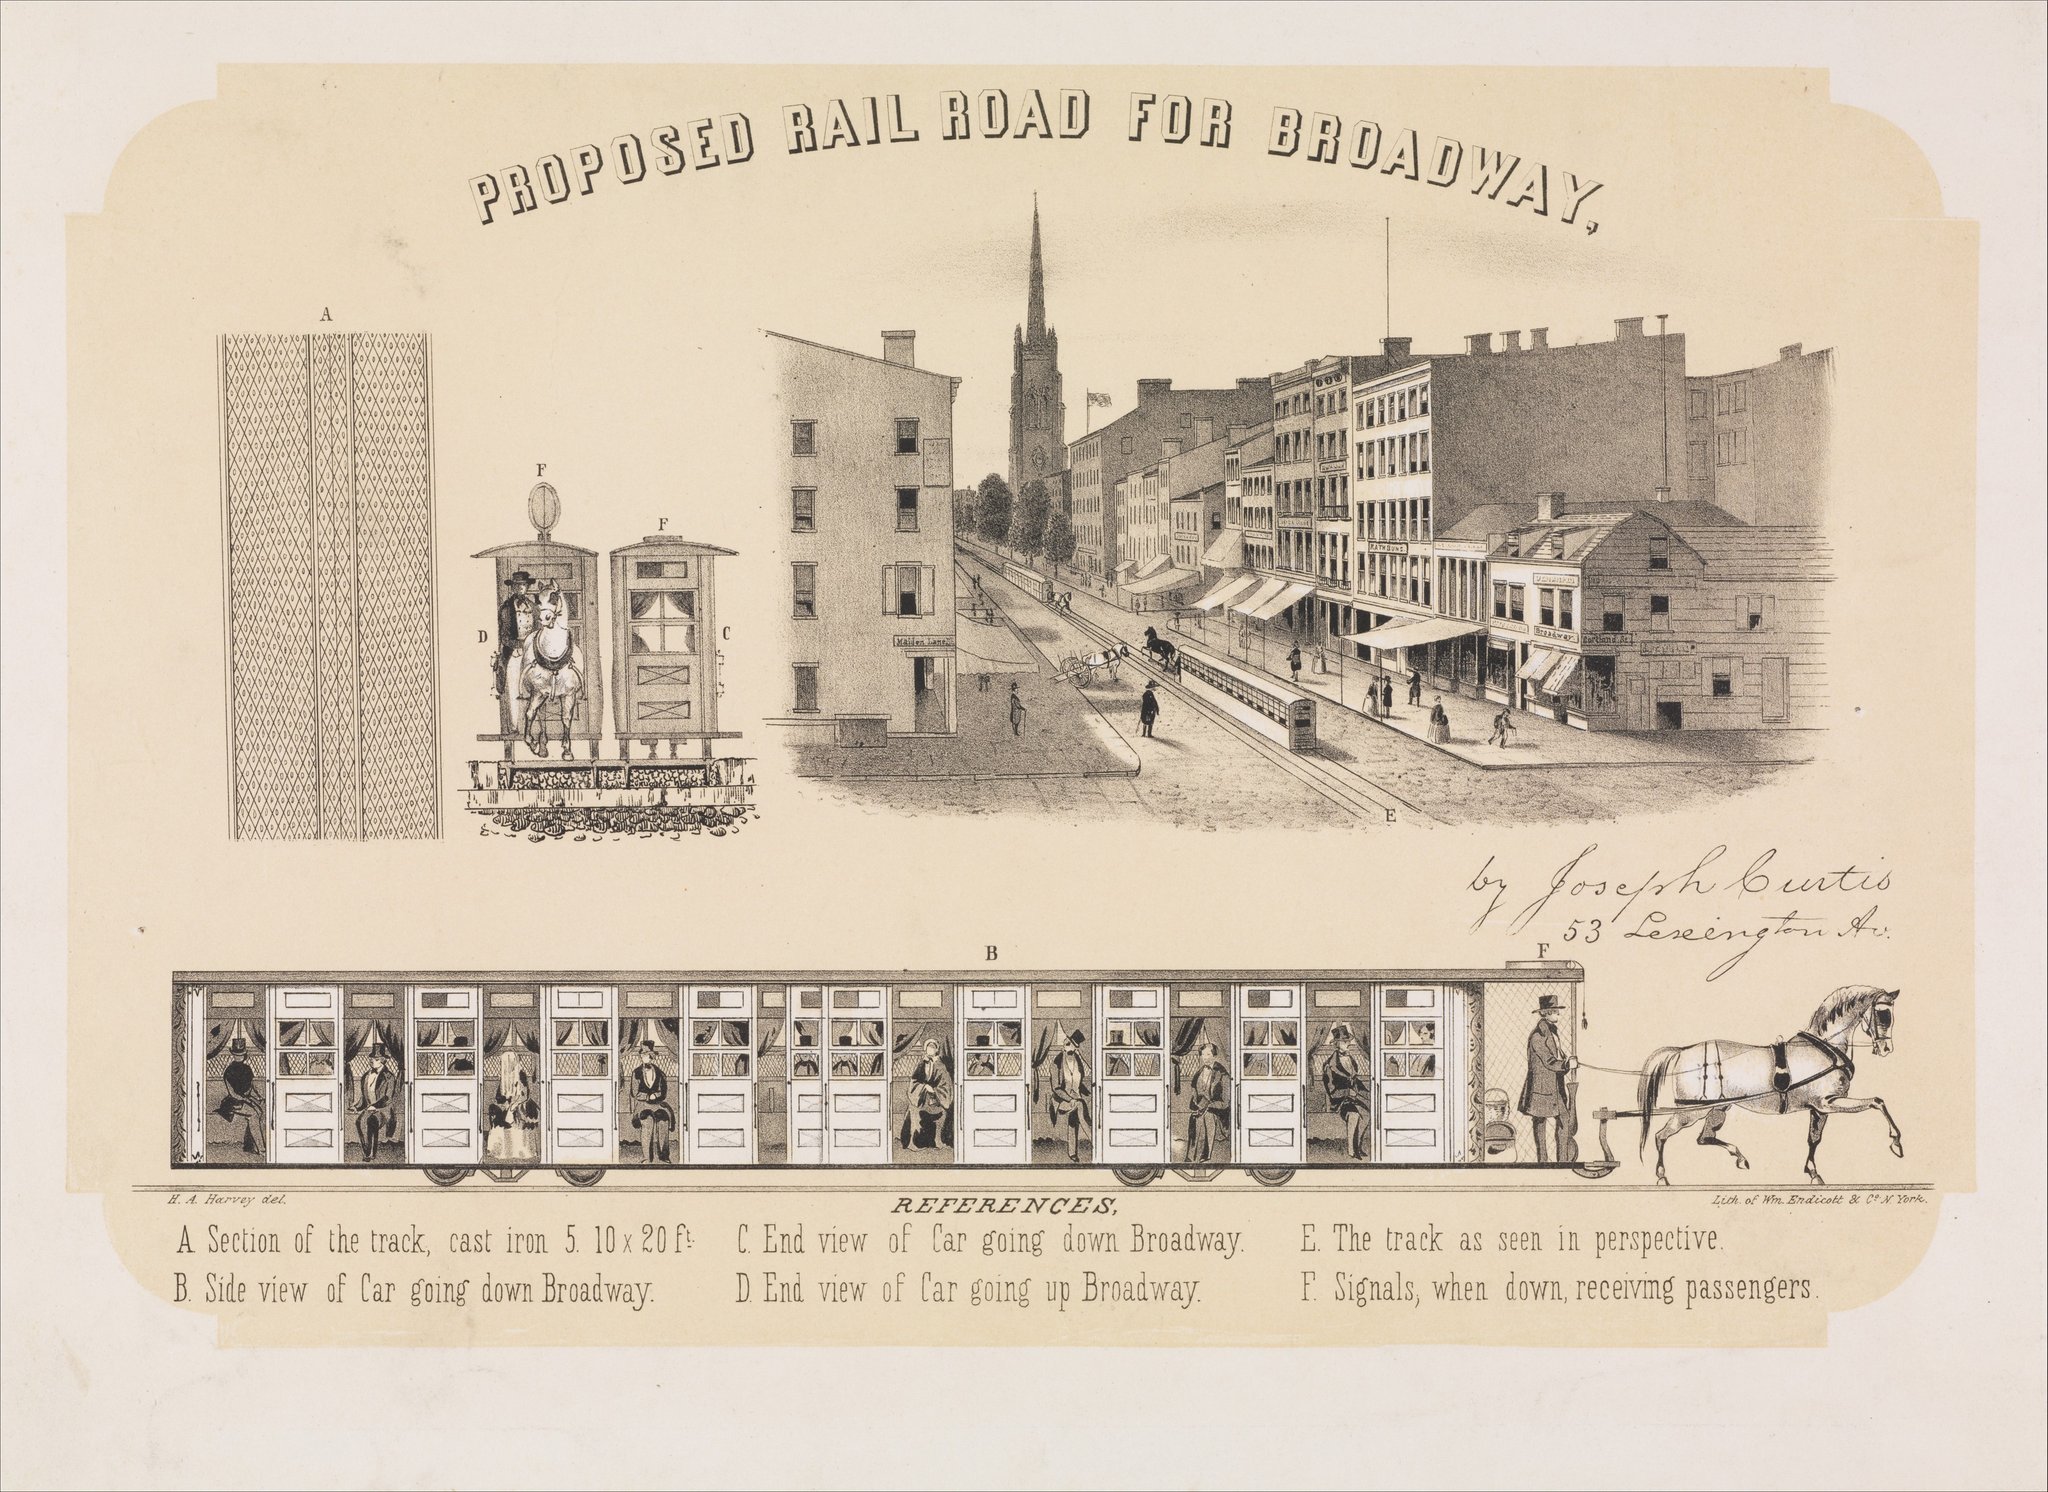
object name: print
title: Proposed Rail Road for Broadway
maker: h. a. harvey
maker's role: artist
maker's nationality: american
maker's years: 1800-1900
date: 1848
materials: stone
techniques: lithograph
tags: cities,railways,horses,streetcars,new york city